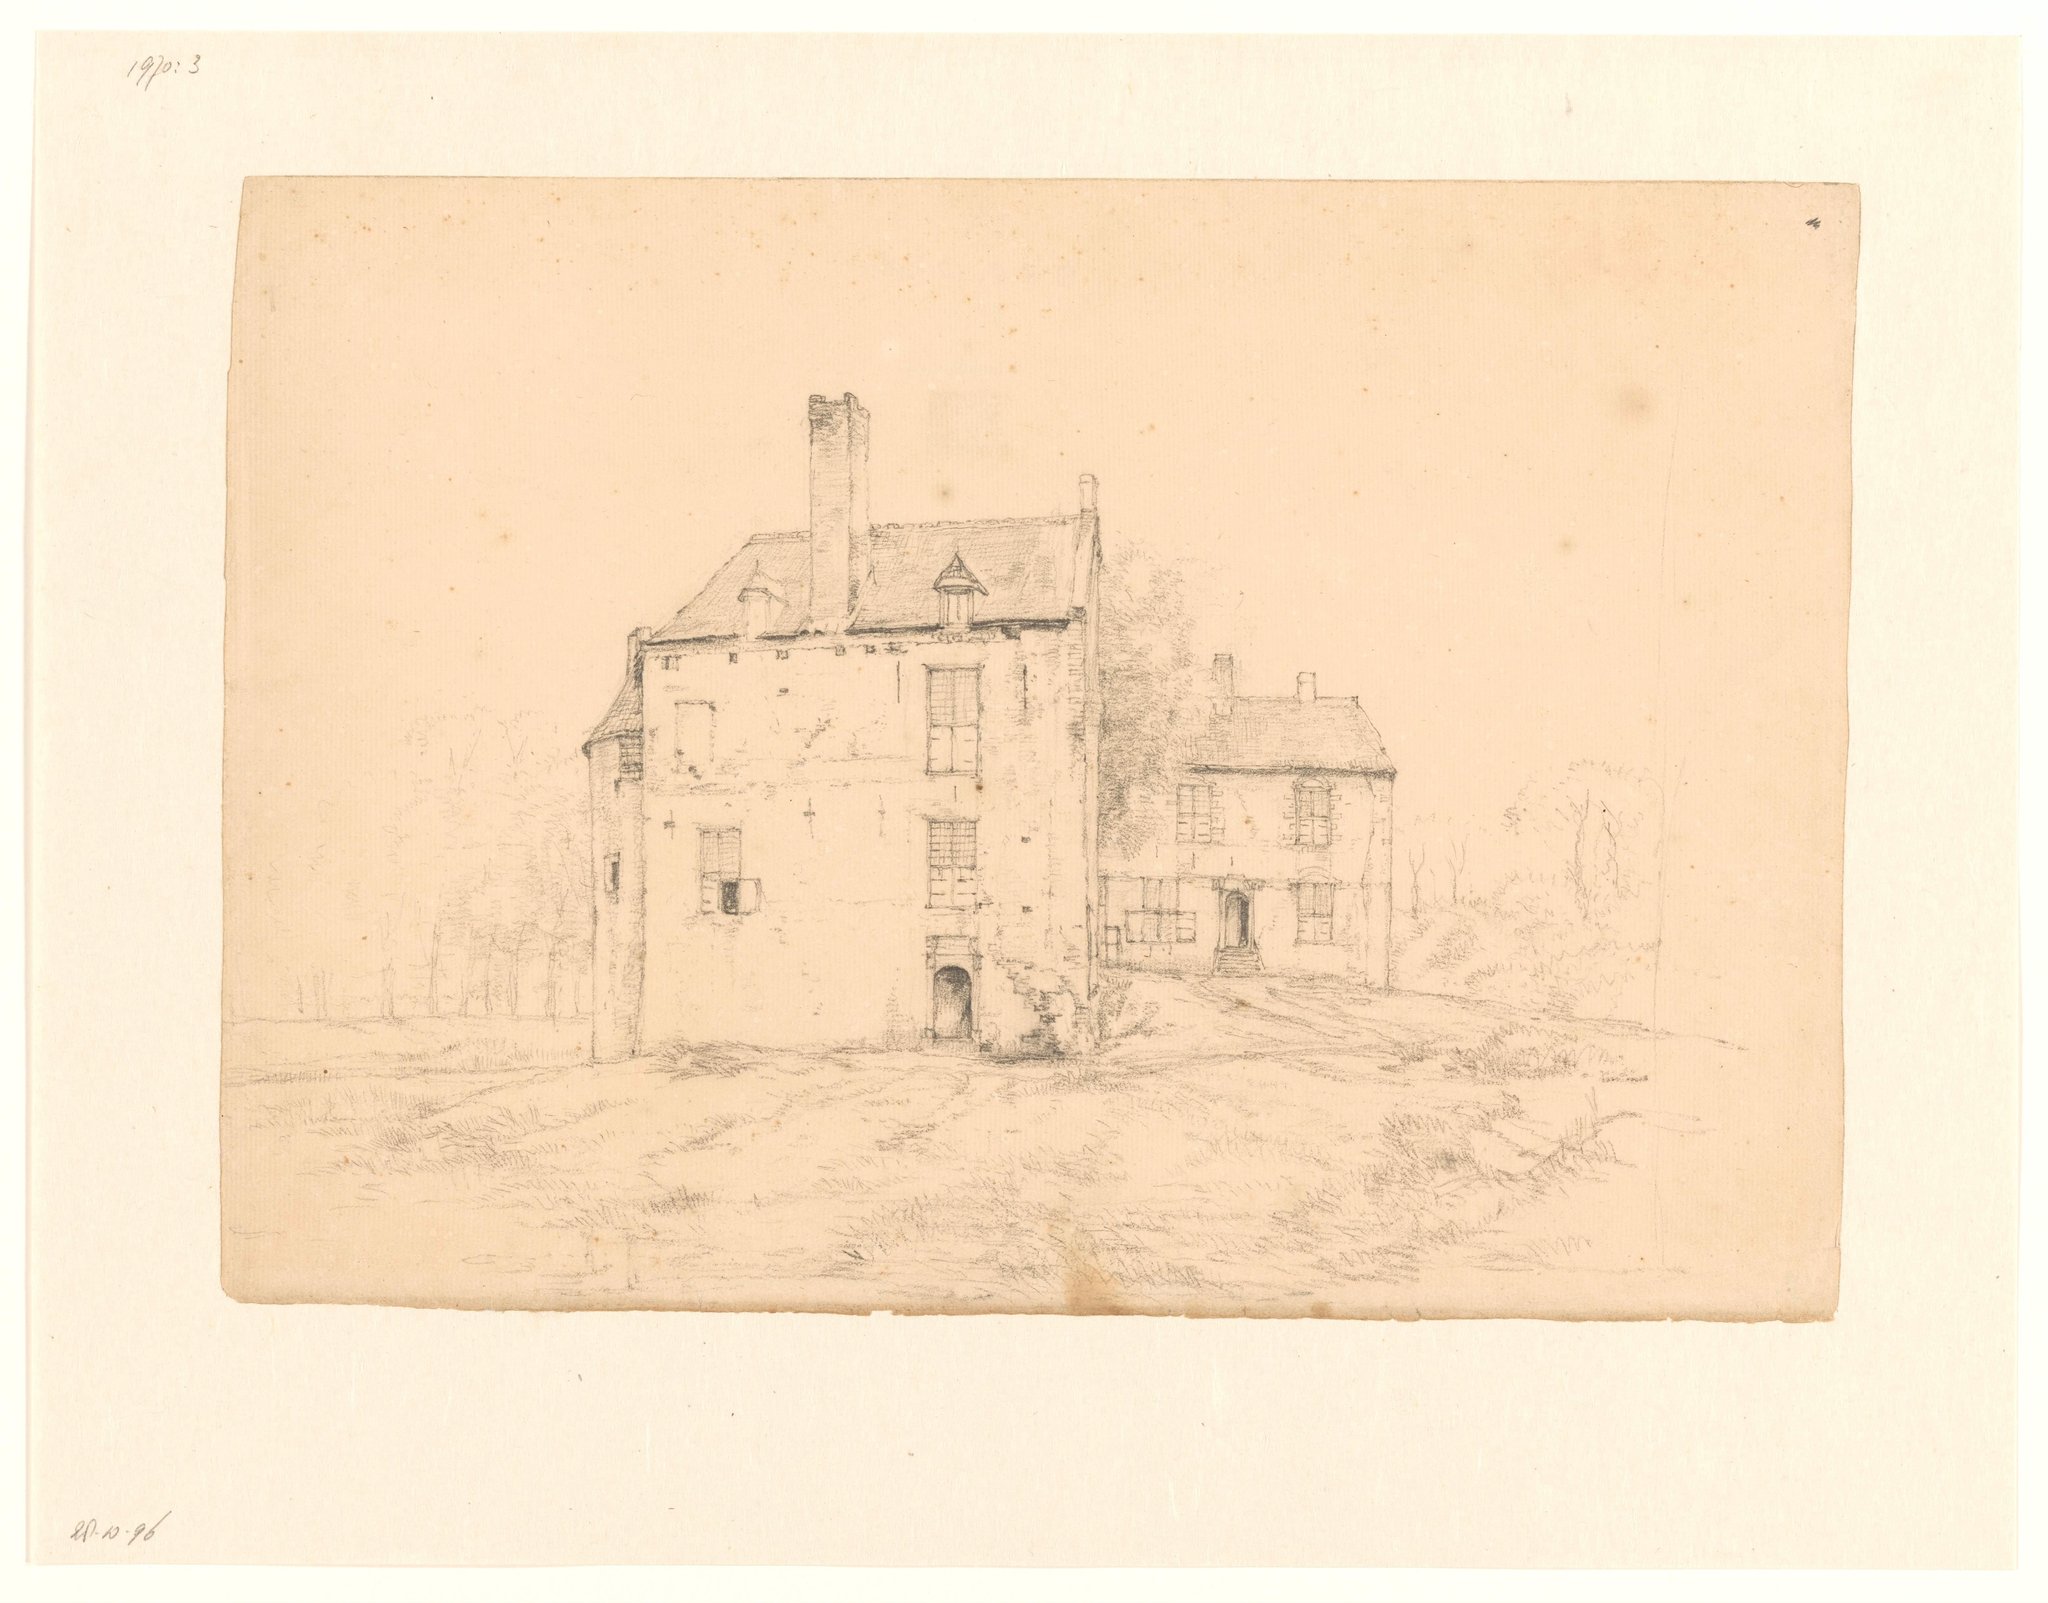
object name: drawing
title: Waardenburg Castle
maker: albertus brondgeest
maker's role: draughtsman, print maker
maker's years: 1786-1849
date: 1796-1849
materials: chalk, paper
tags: castle